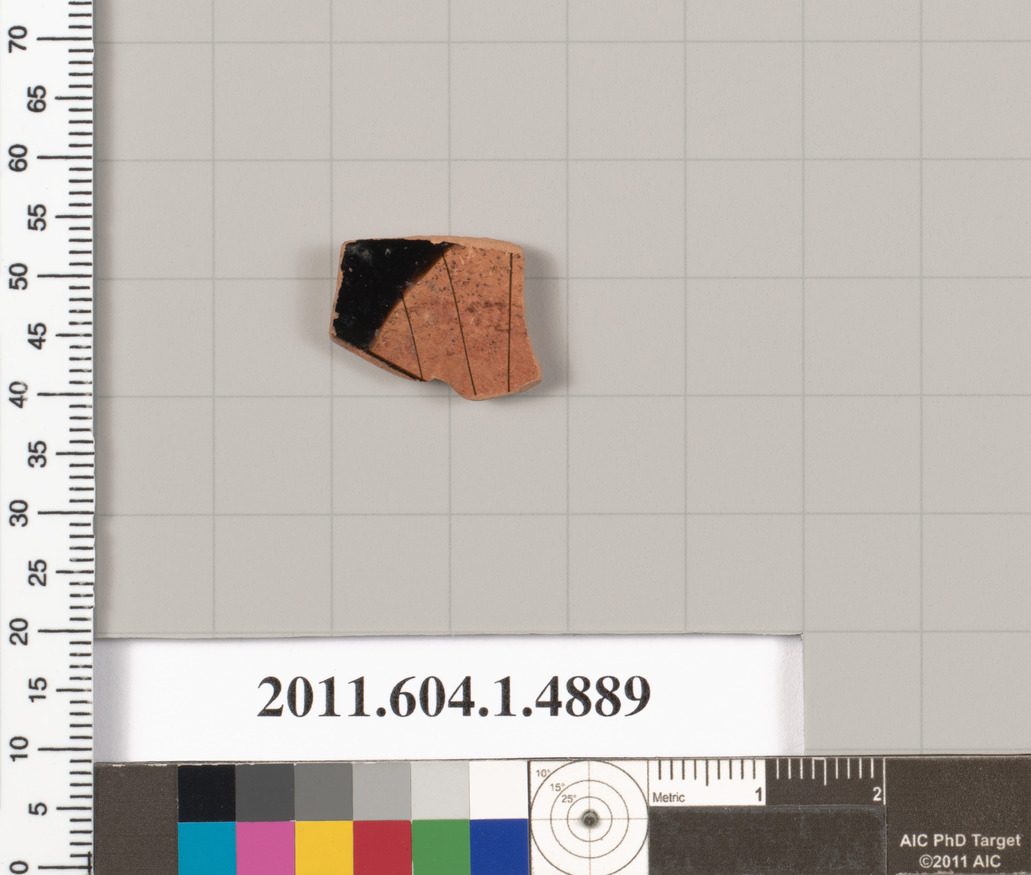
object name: kylix fragment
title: Terracotta fragment of a kylix (drinking cup)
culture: greek, attic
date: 475-451 BCE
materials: terracotta